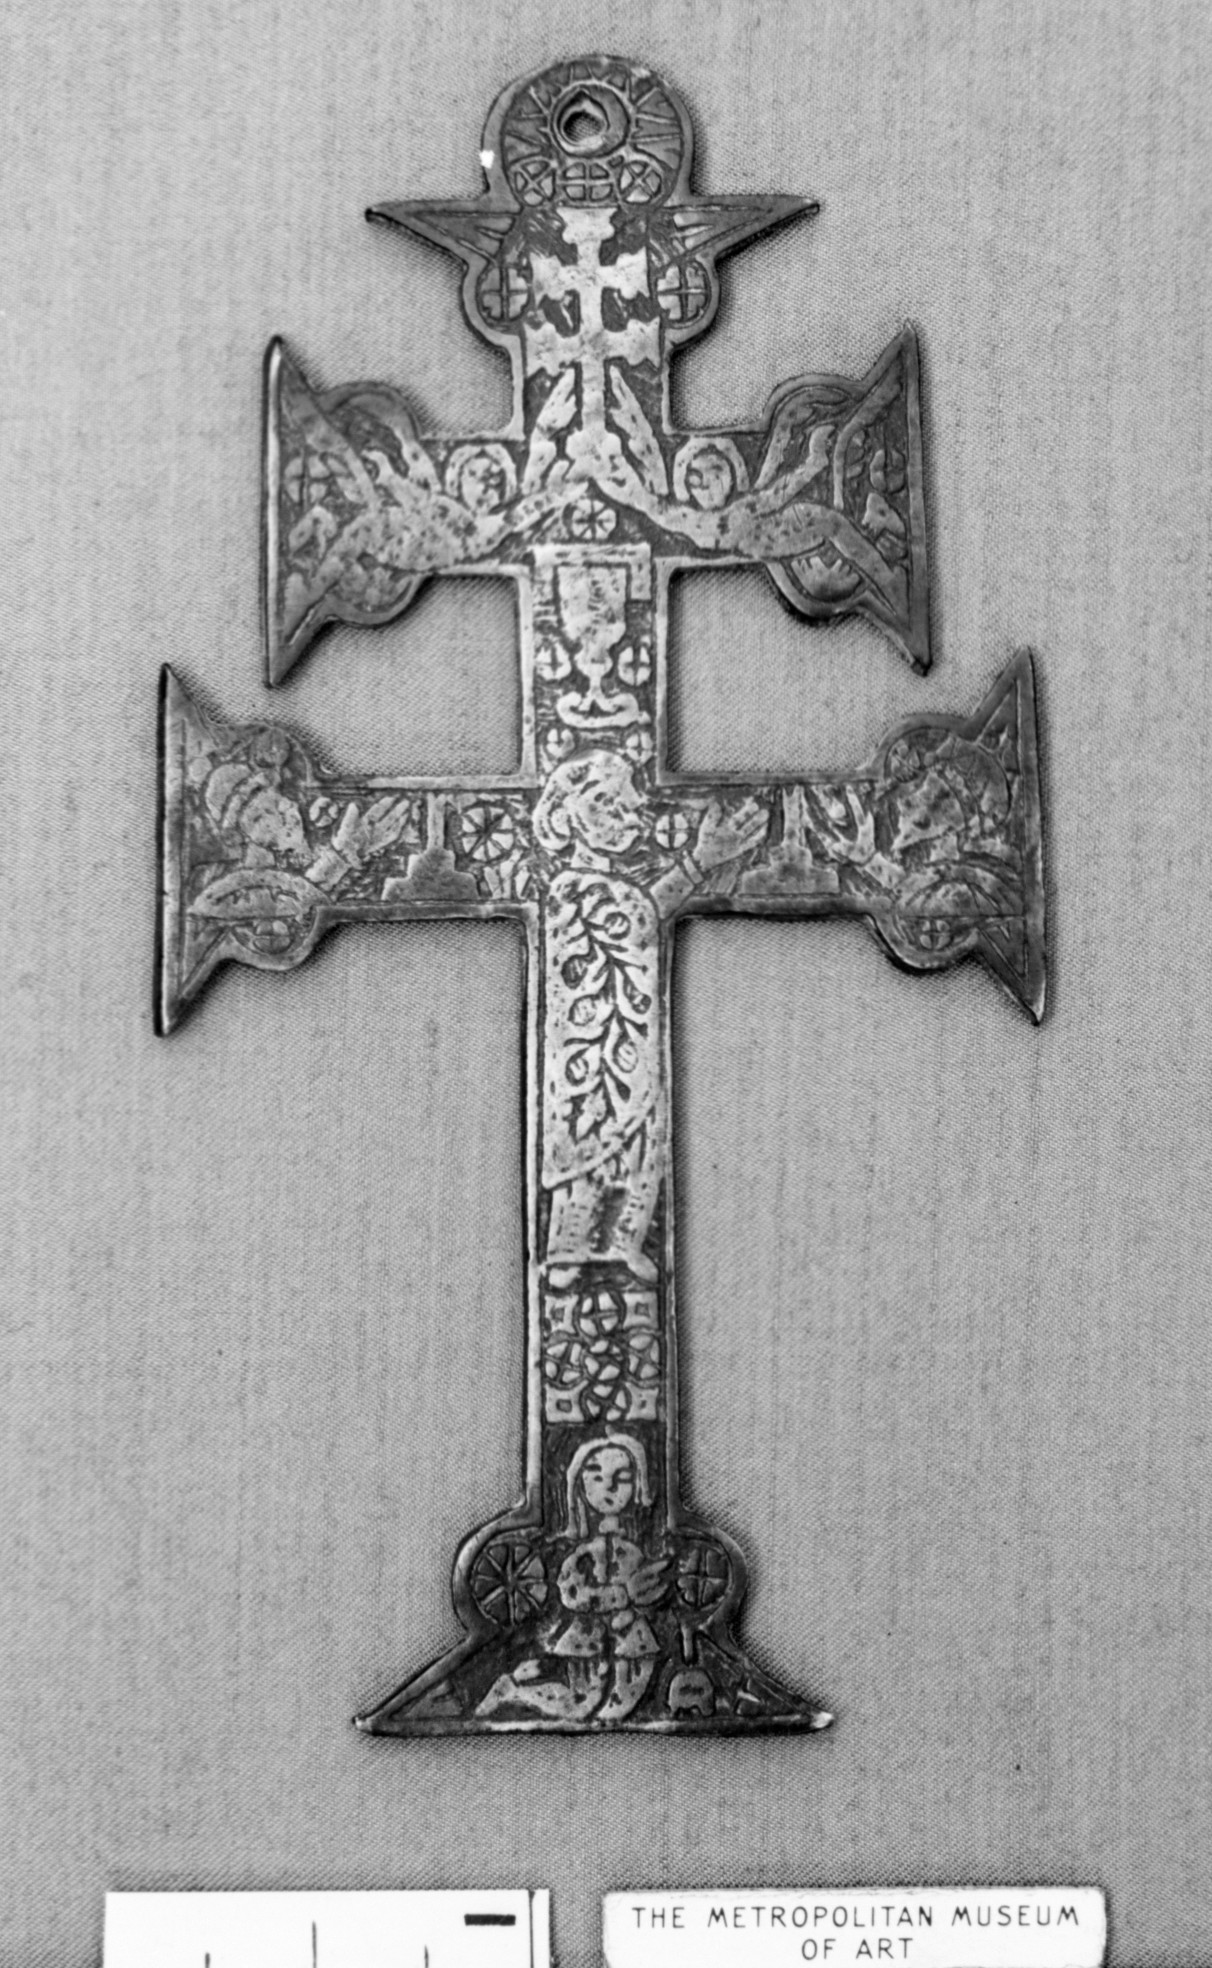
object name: cross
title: Devotional portable cross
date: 1751-1775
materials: bronze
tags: men,angels,cross